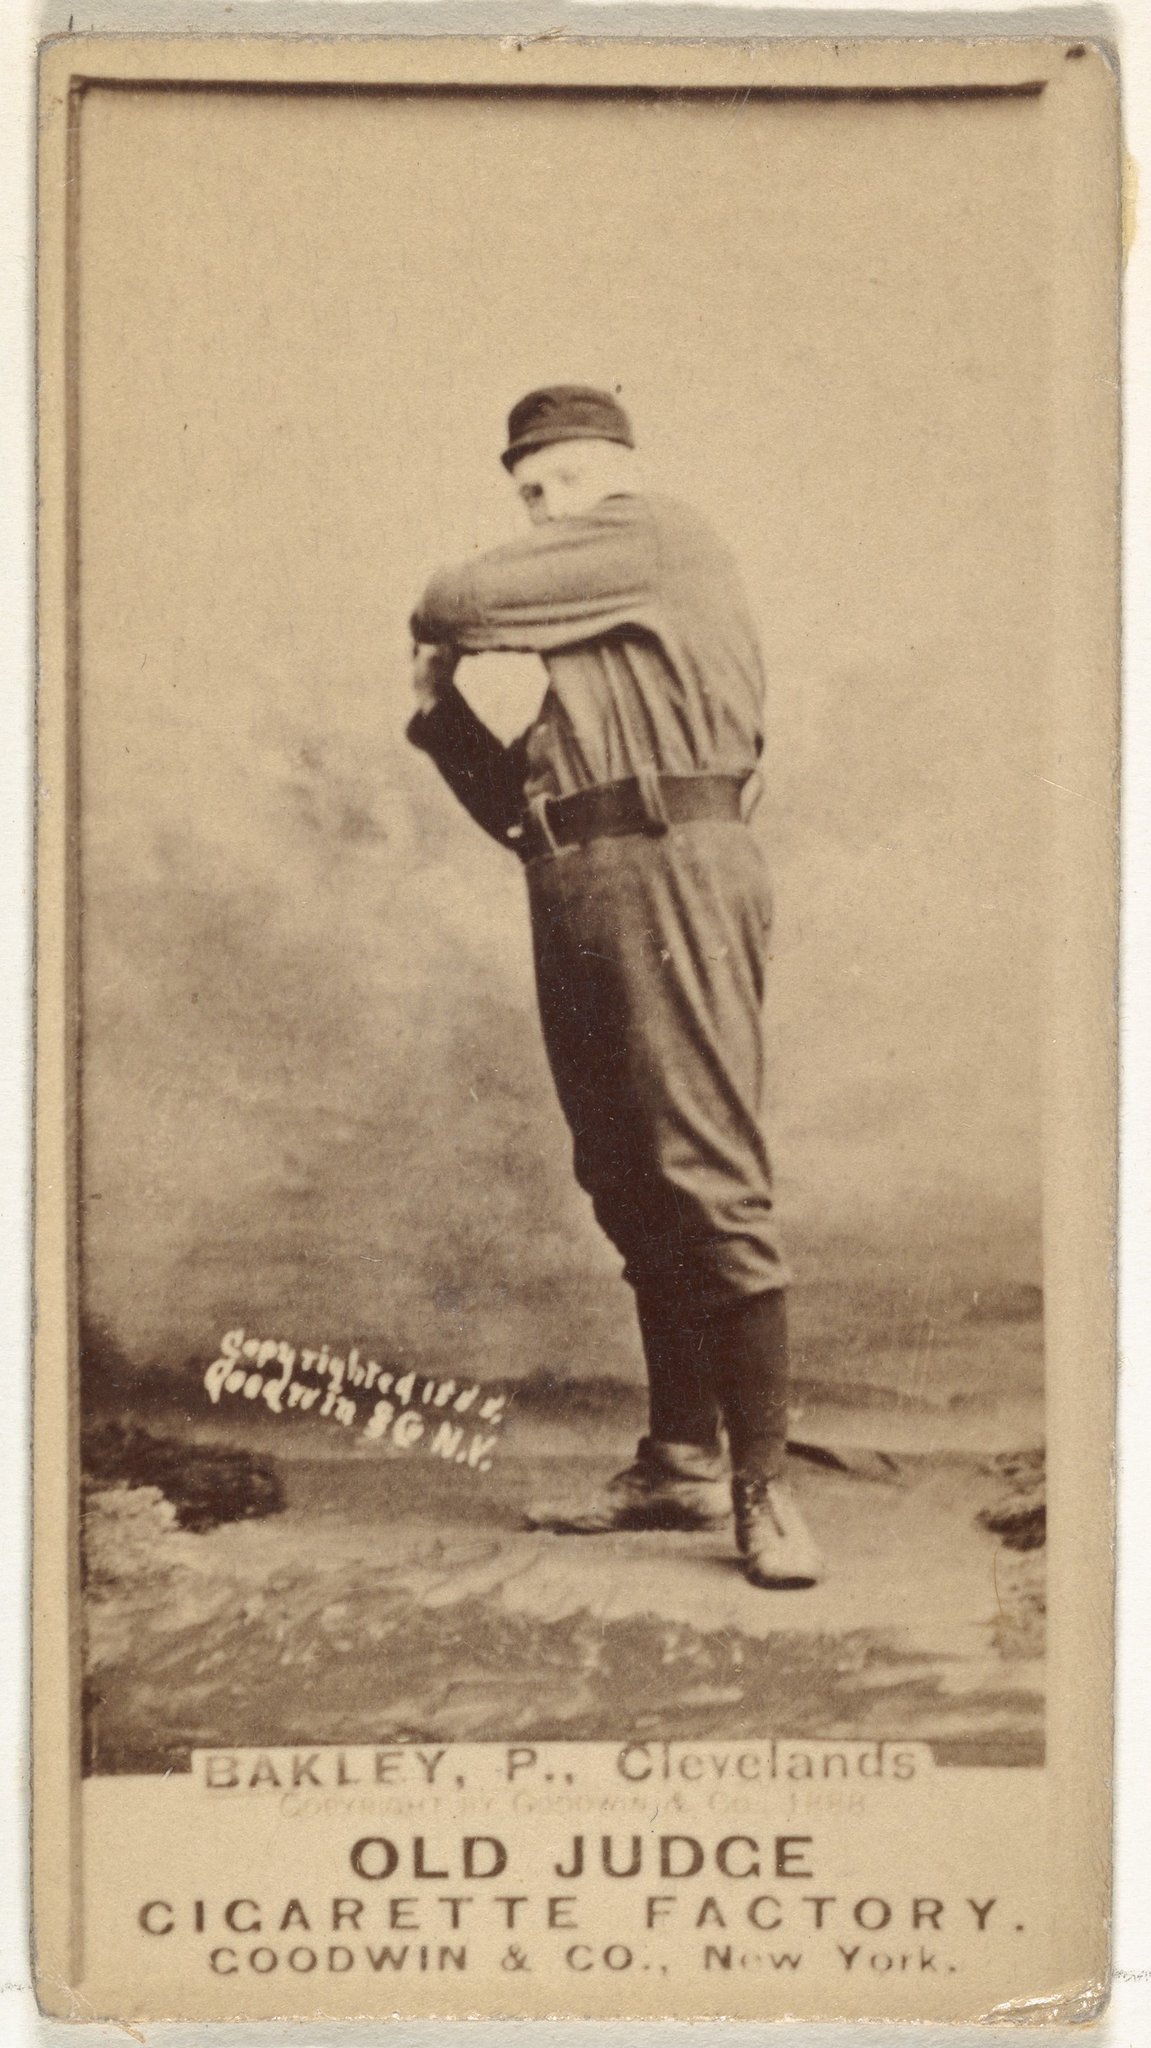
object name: baseball card, photograph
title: Edward Enoch "Jersey" Bakely, Pitcher, Cleveland, from the Old Judge series (N172) for Old Judge Cigarettes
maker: goodwin & company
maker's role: publisher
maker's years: 1850-1950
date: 1888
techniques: albumen silver print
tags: men,portraits,baseball,athletes